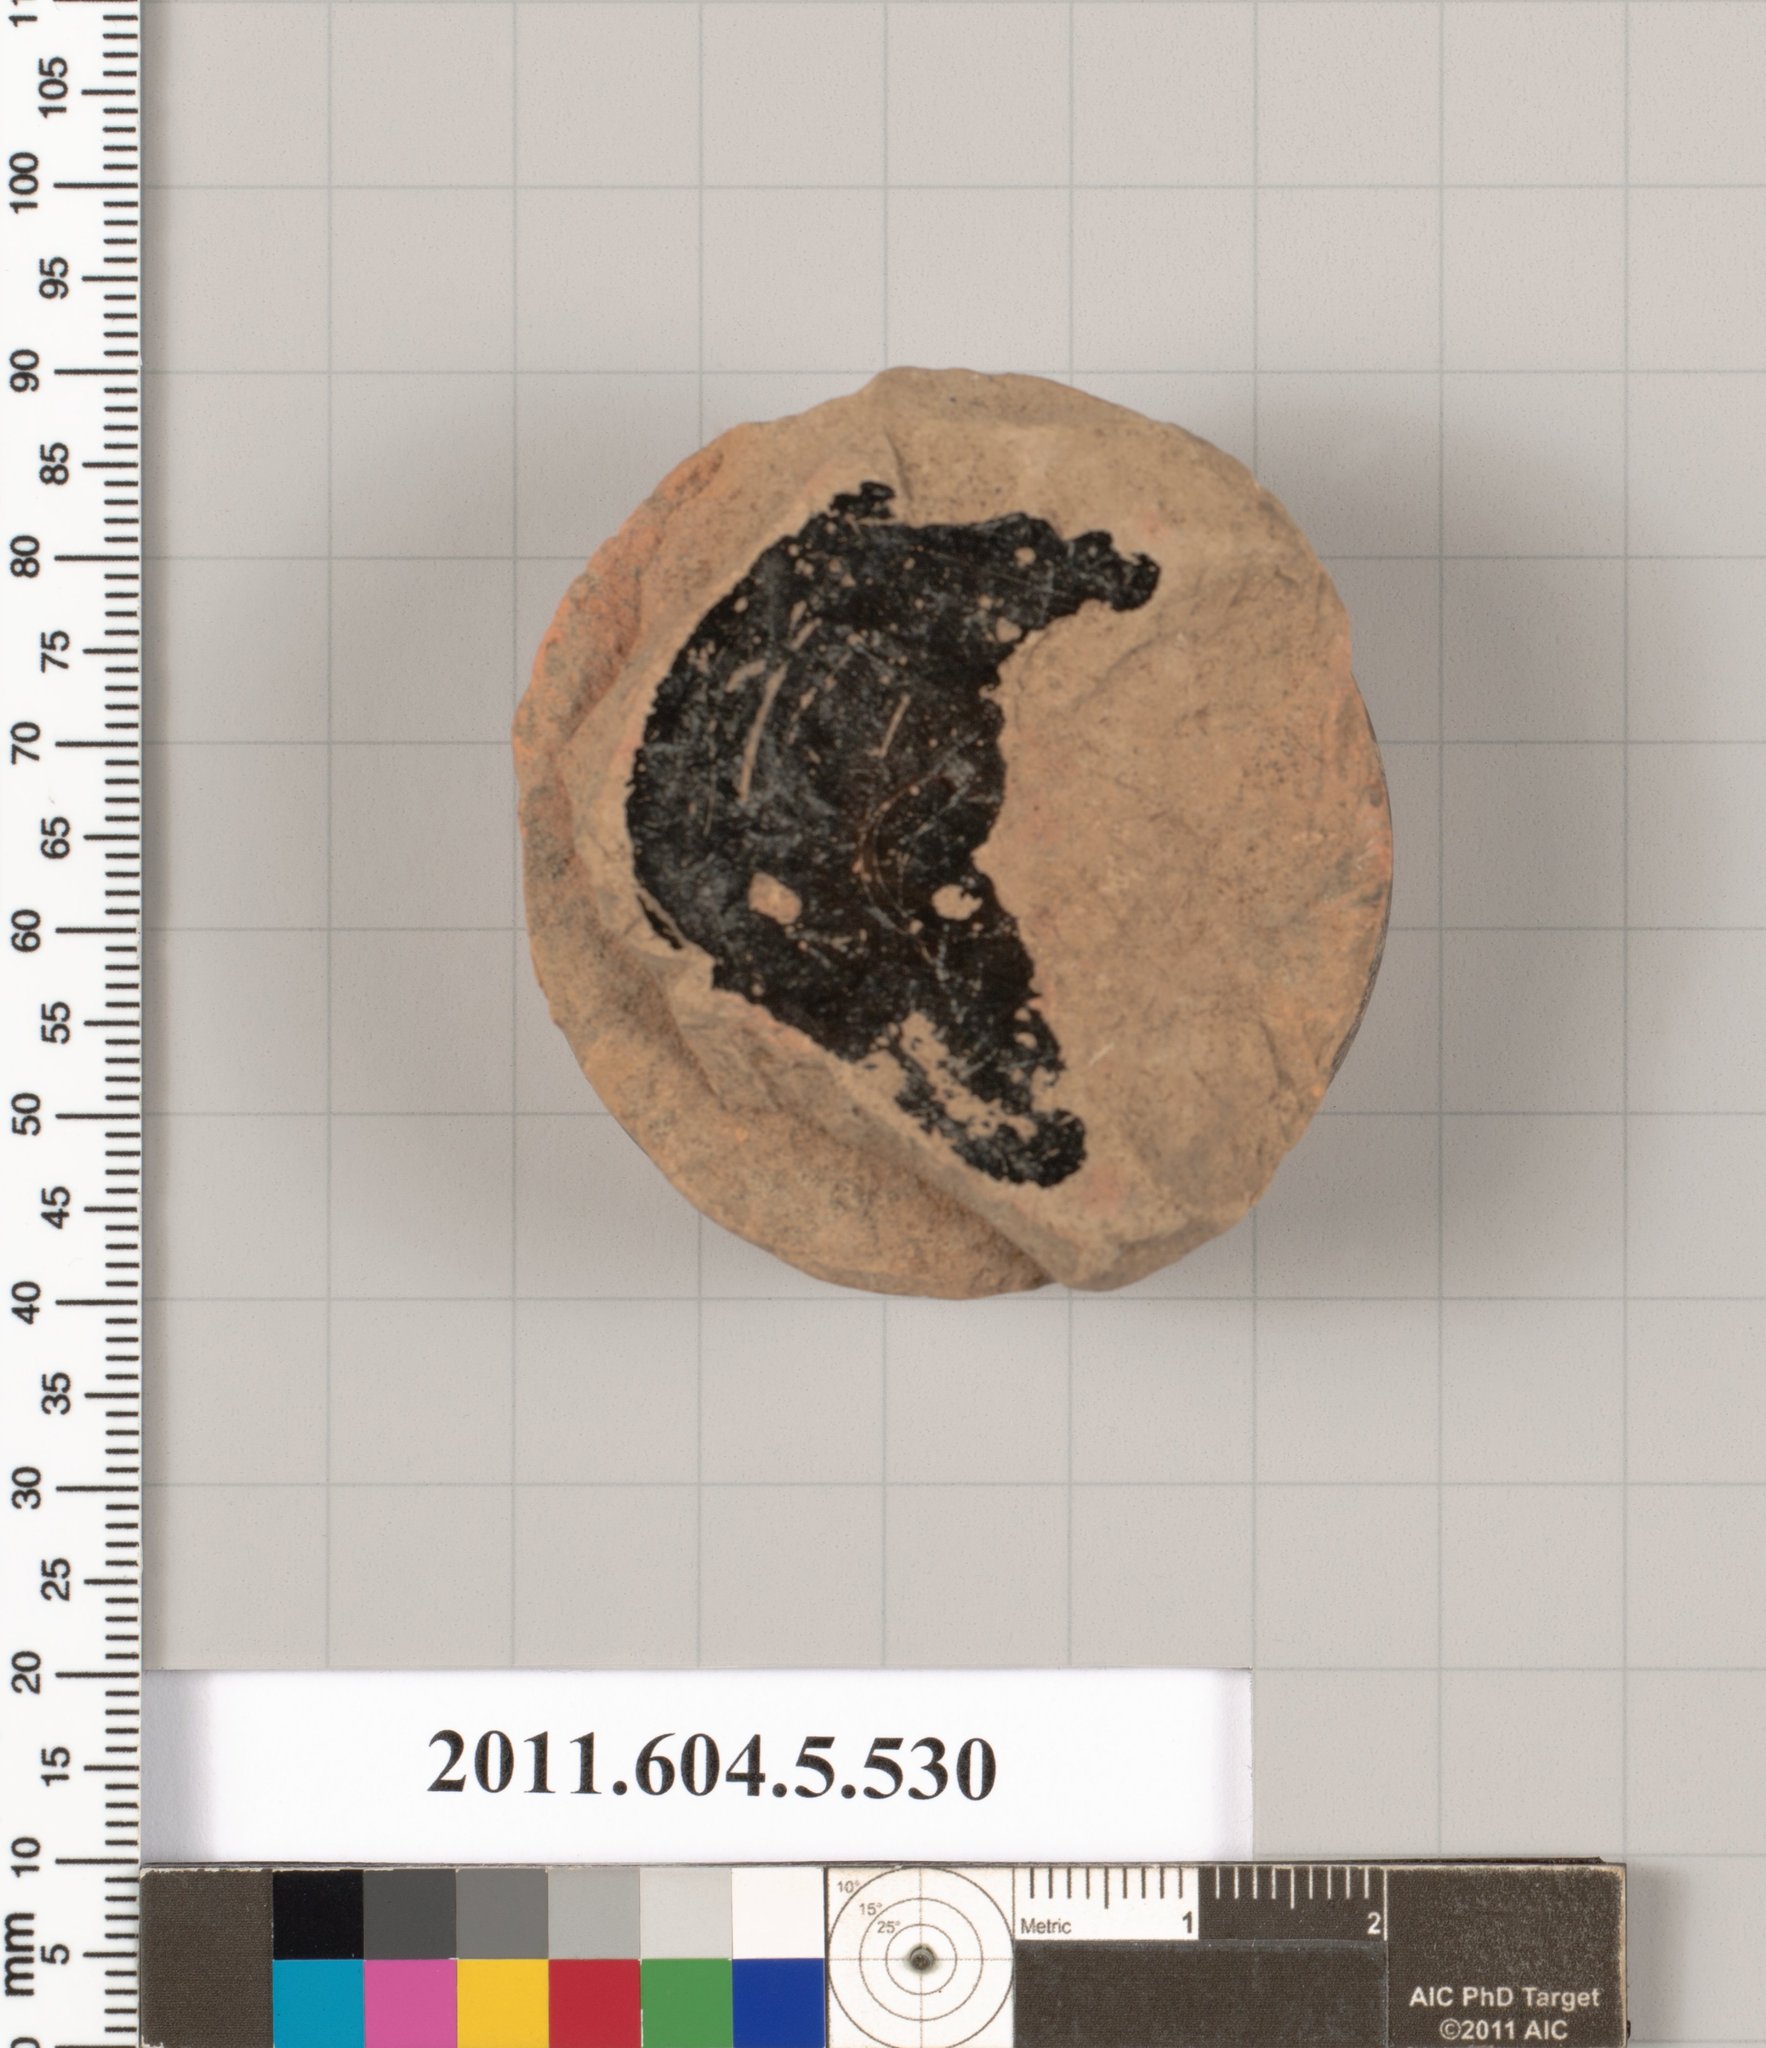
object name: kylix fragment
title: Terracotta fragment of a kylix (drinking cup)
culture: greek, attic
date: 600-401 BCE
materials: terracotta